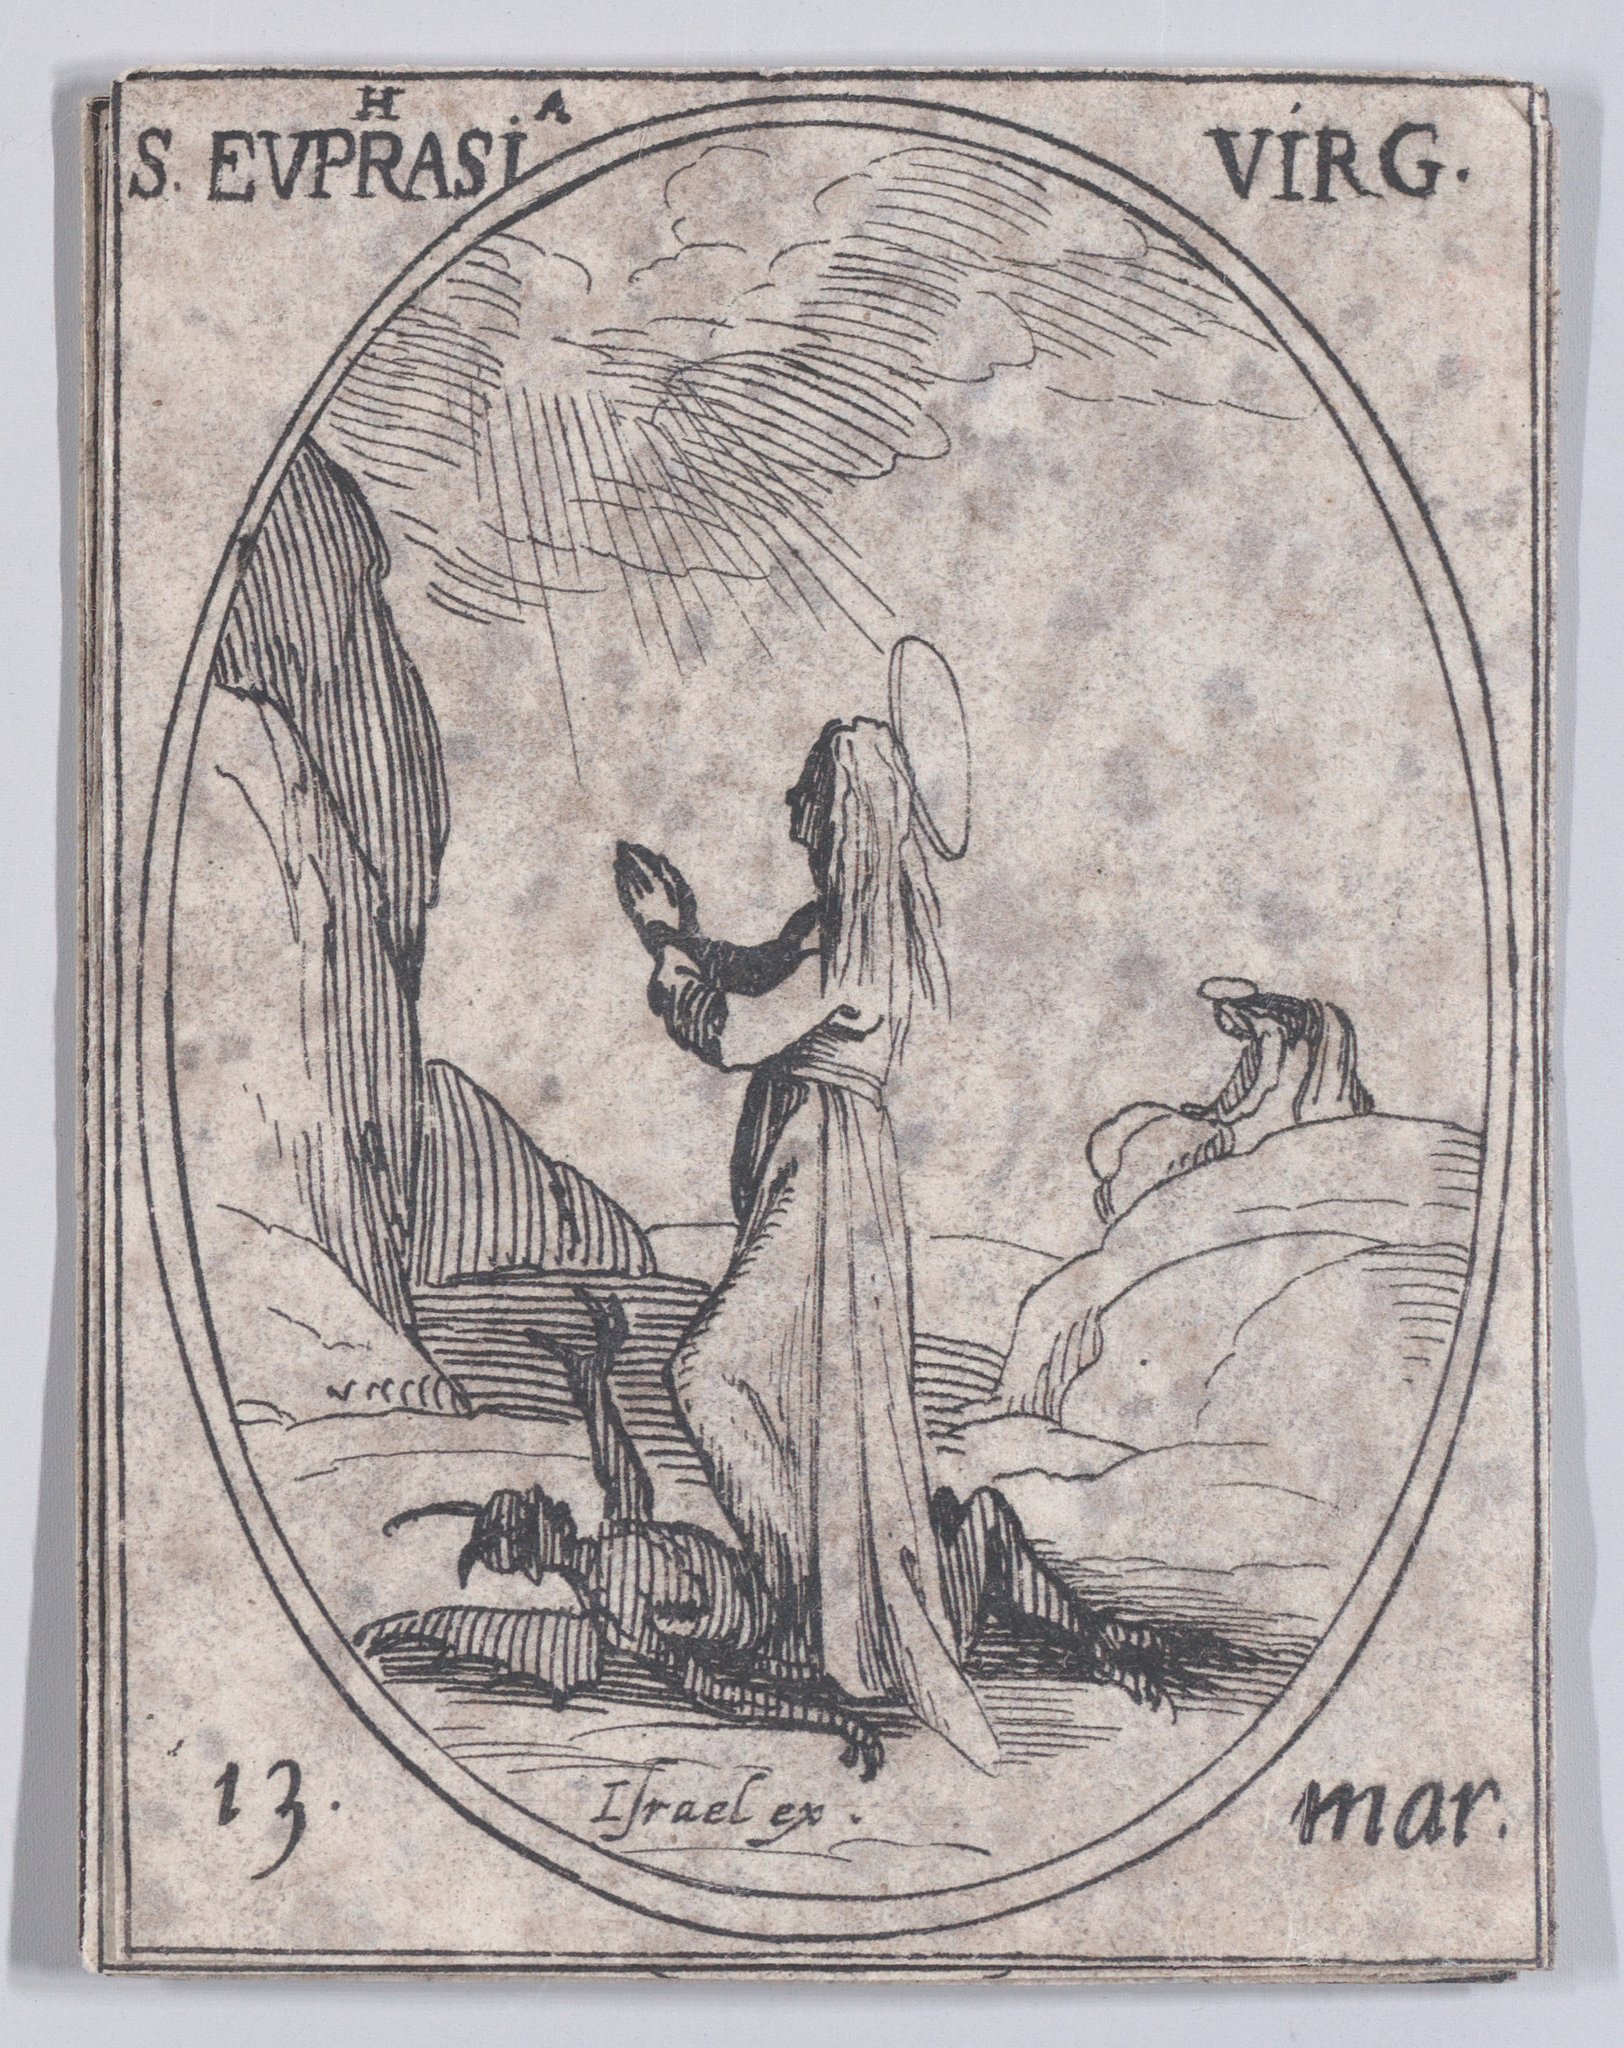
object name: print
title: Ste. Euphraise, vierge (St. Euphrasia, Virgin), March 13th, from "Les Images De Tous Les Saincts et Saintes de L'Année" (Images of All of the Saints and Religious Events of the Year)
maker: jacques callot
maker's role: artist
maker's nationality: french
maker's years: 1592-1635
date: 1636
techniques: etching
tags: women,saints